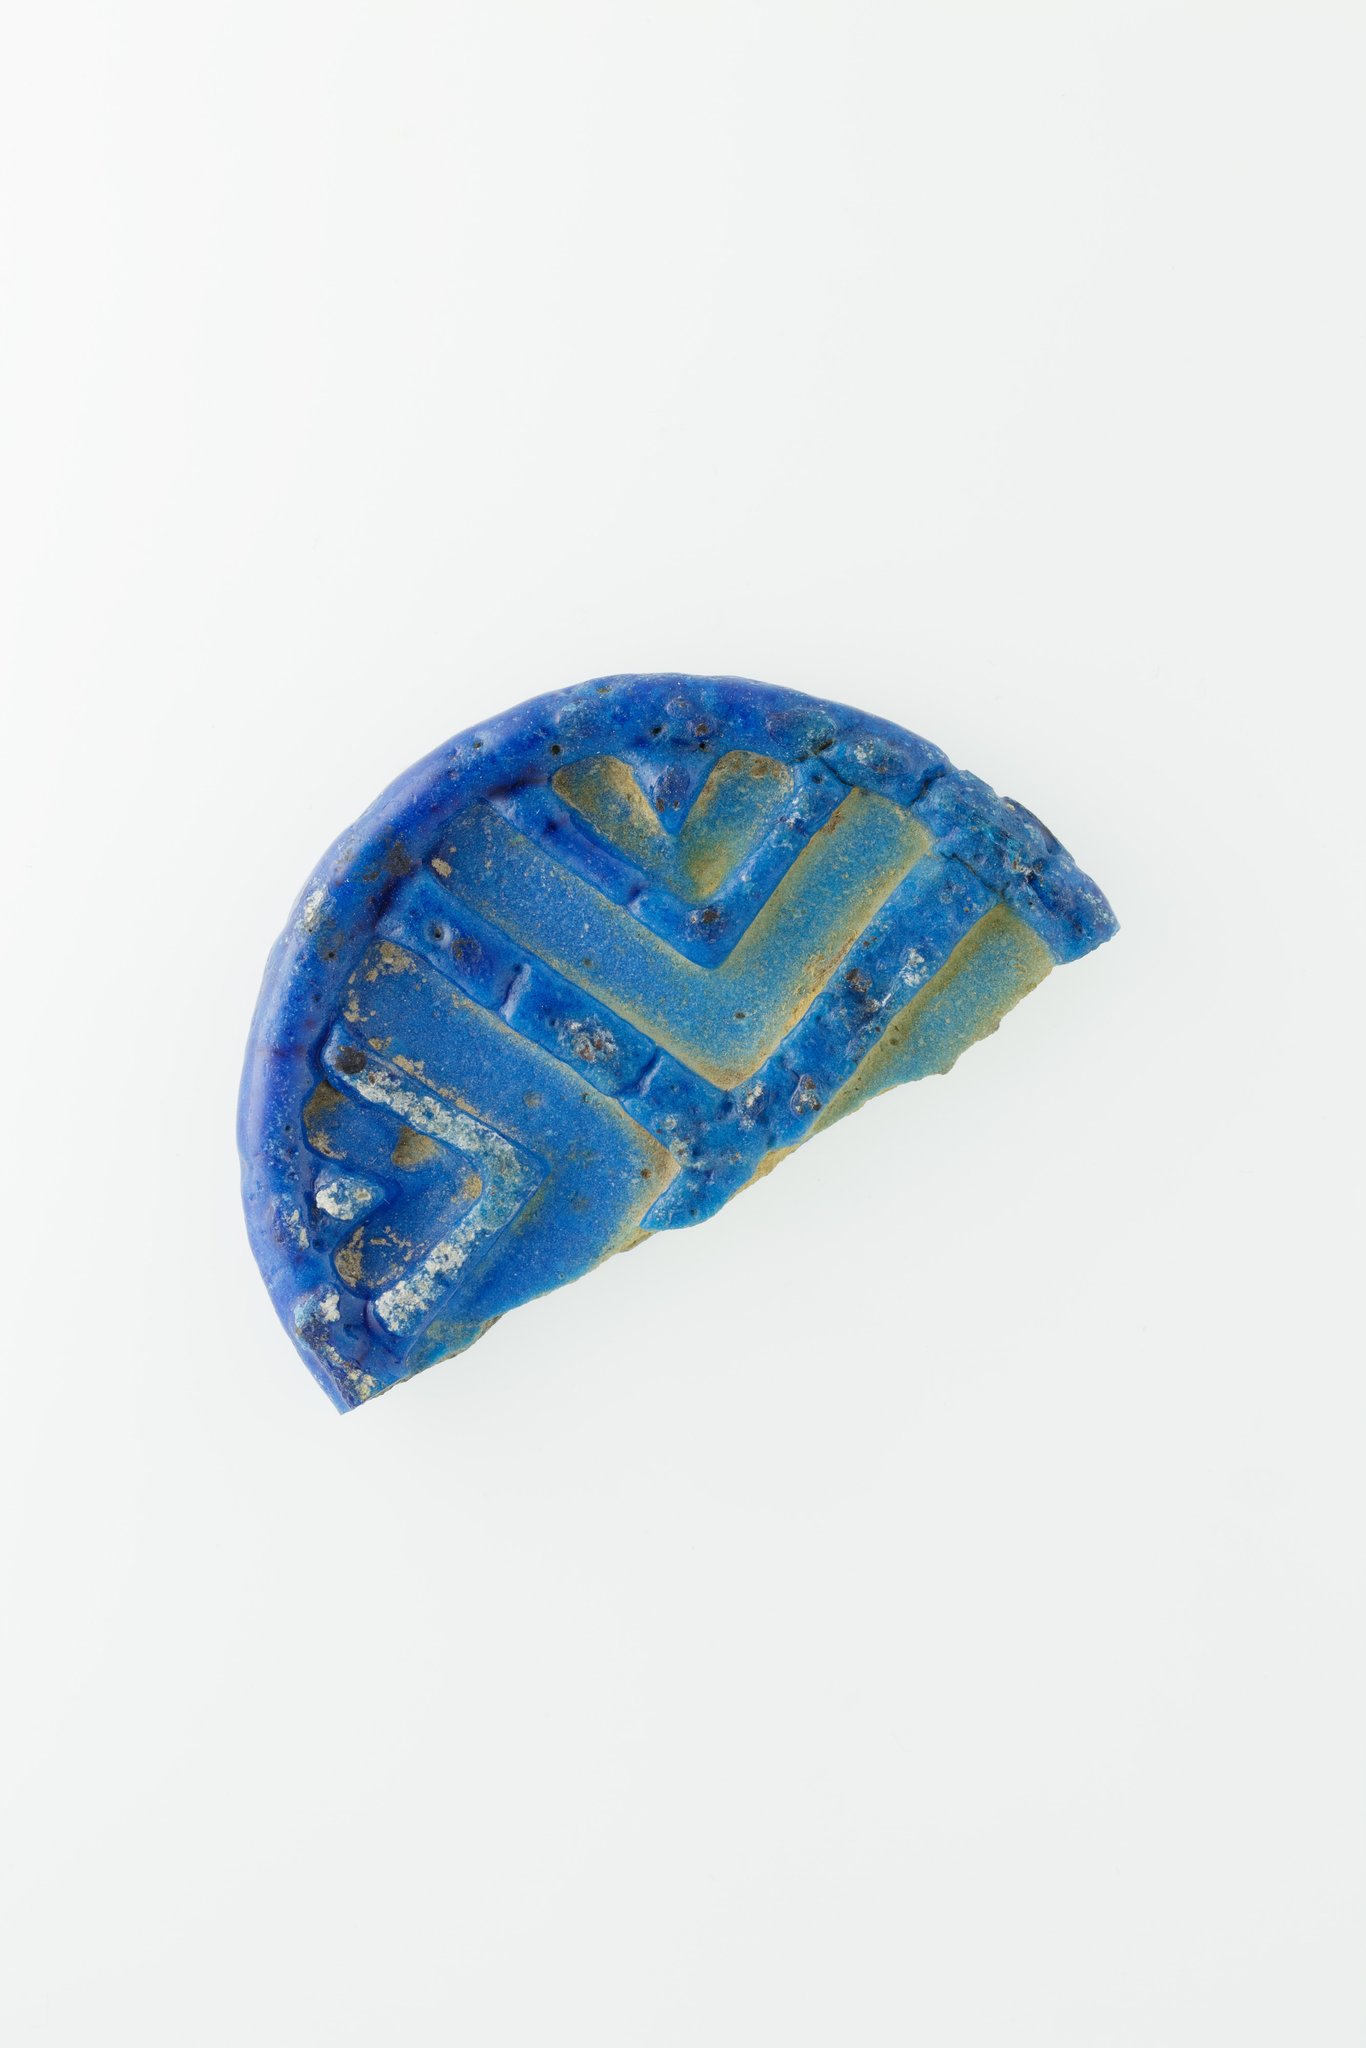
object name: inlay, hieroglyph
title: Inlay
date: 664-610 BCE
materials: faience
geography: egypt